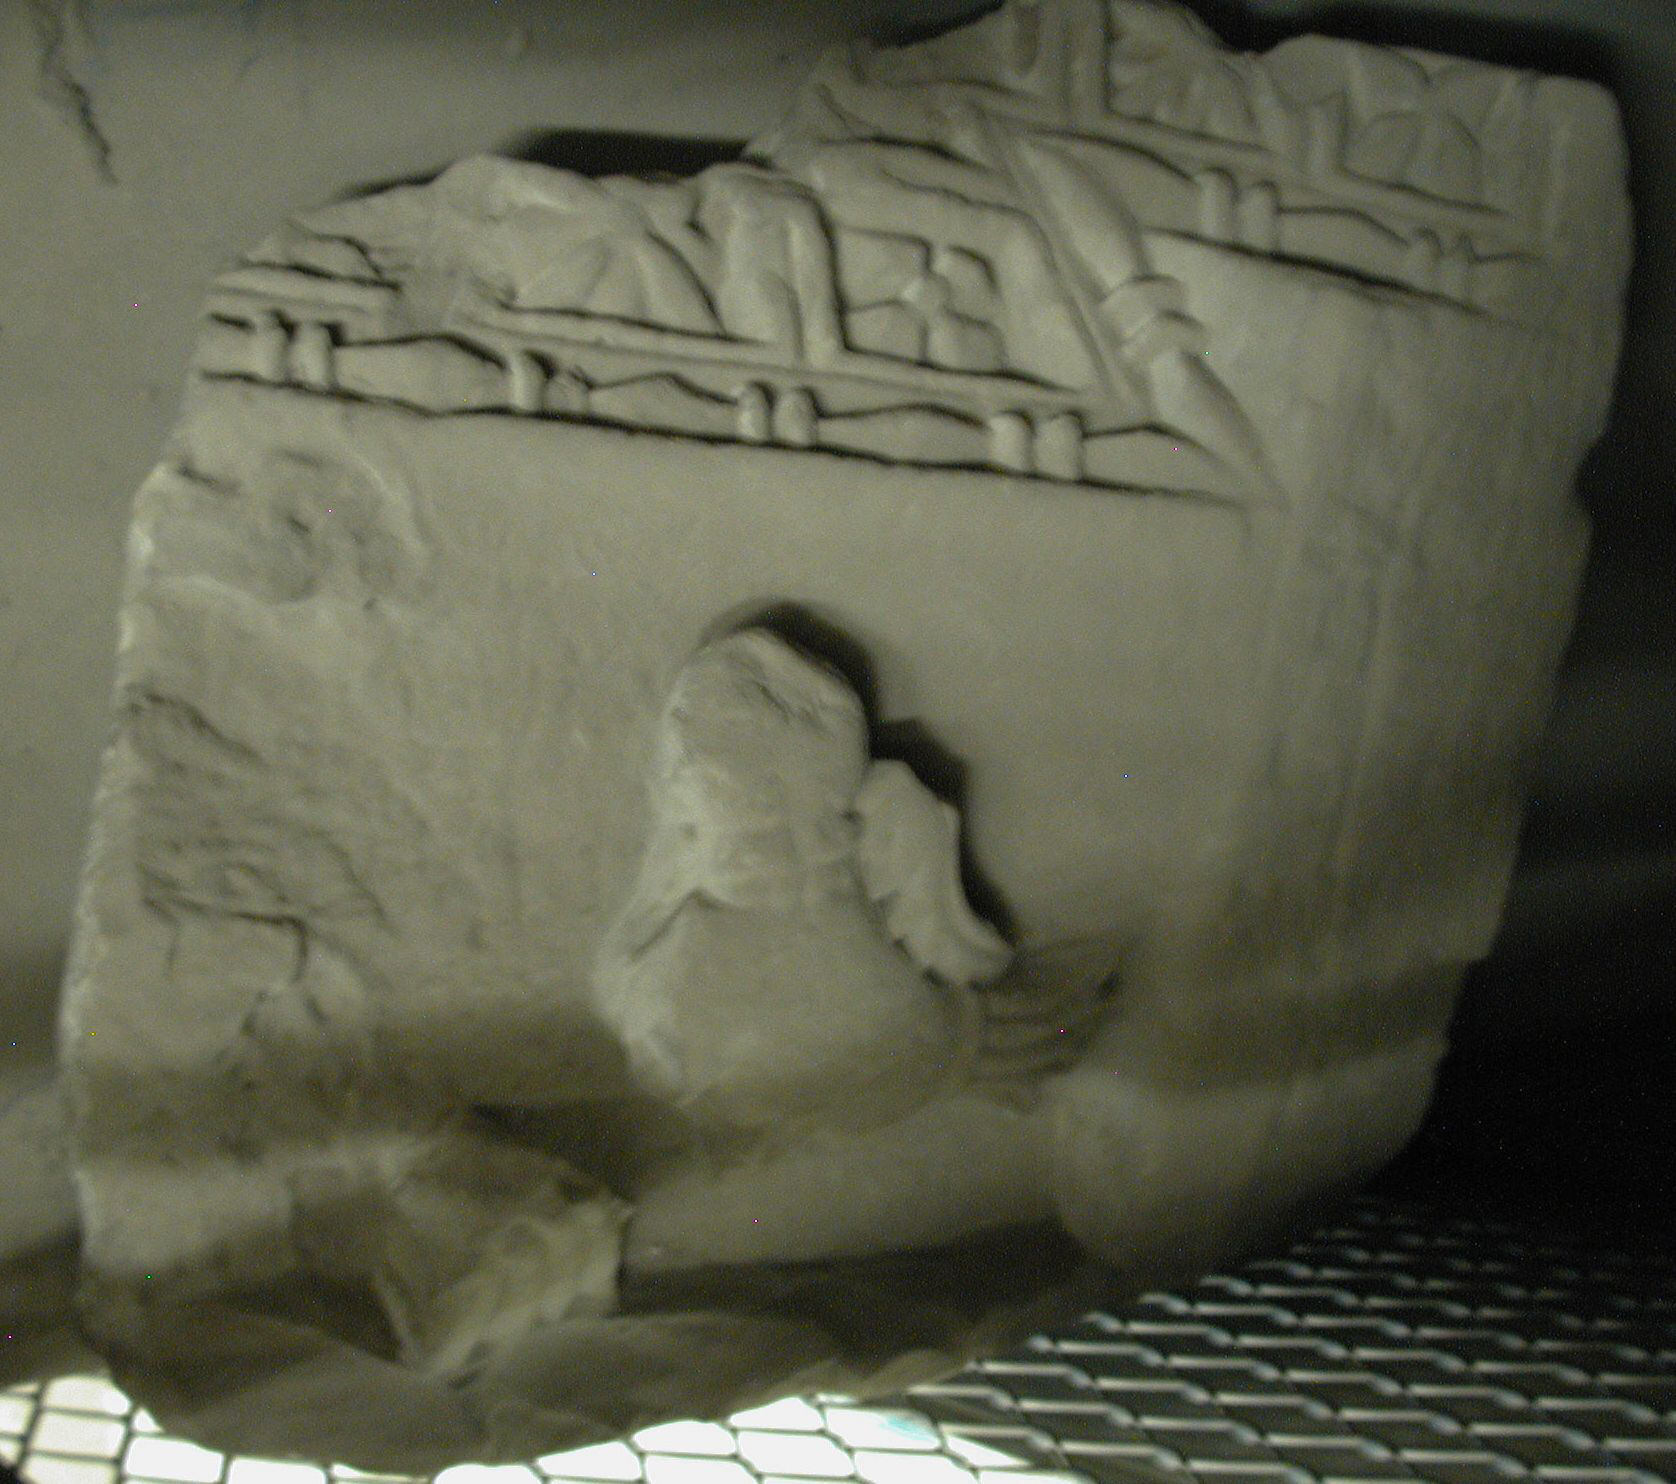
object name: fragment of a cornice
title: Fragment of a Cornice with a Bird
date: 301-500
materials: limestone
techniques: carving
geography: egypt